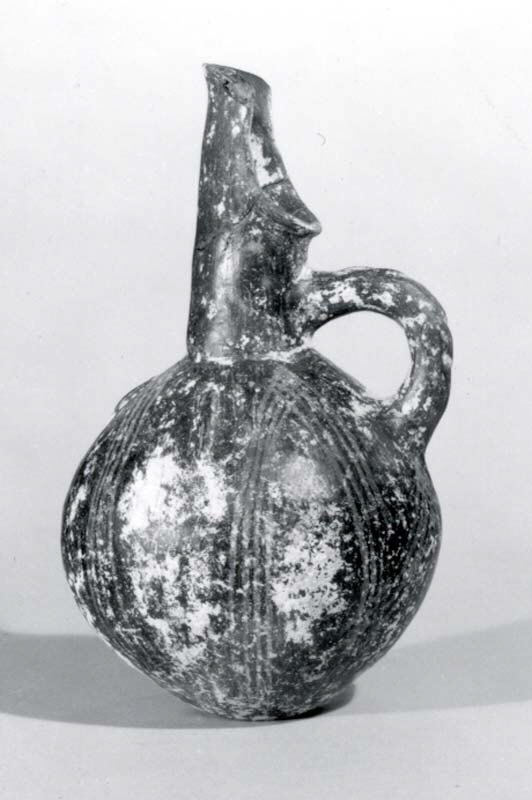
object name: jar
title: Jar with spout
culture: yortan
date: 2700-2400 BCE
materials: ceramic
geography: northwestern anatolia